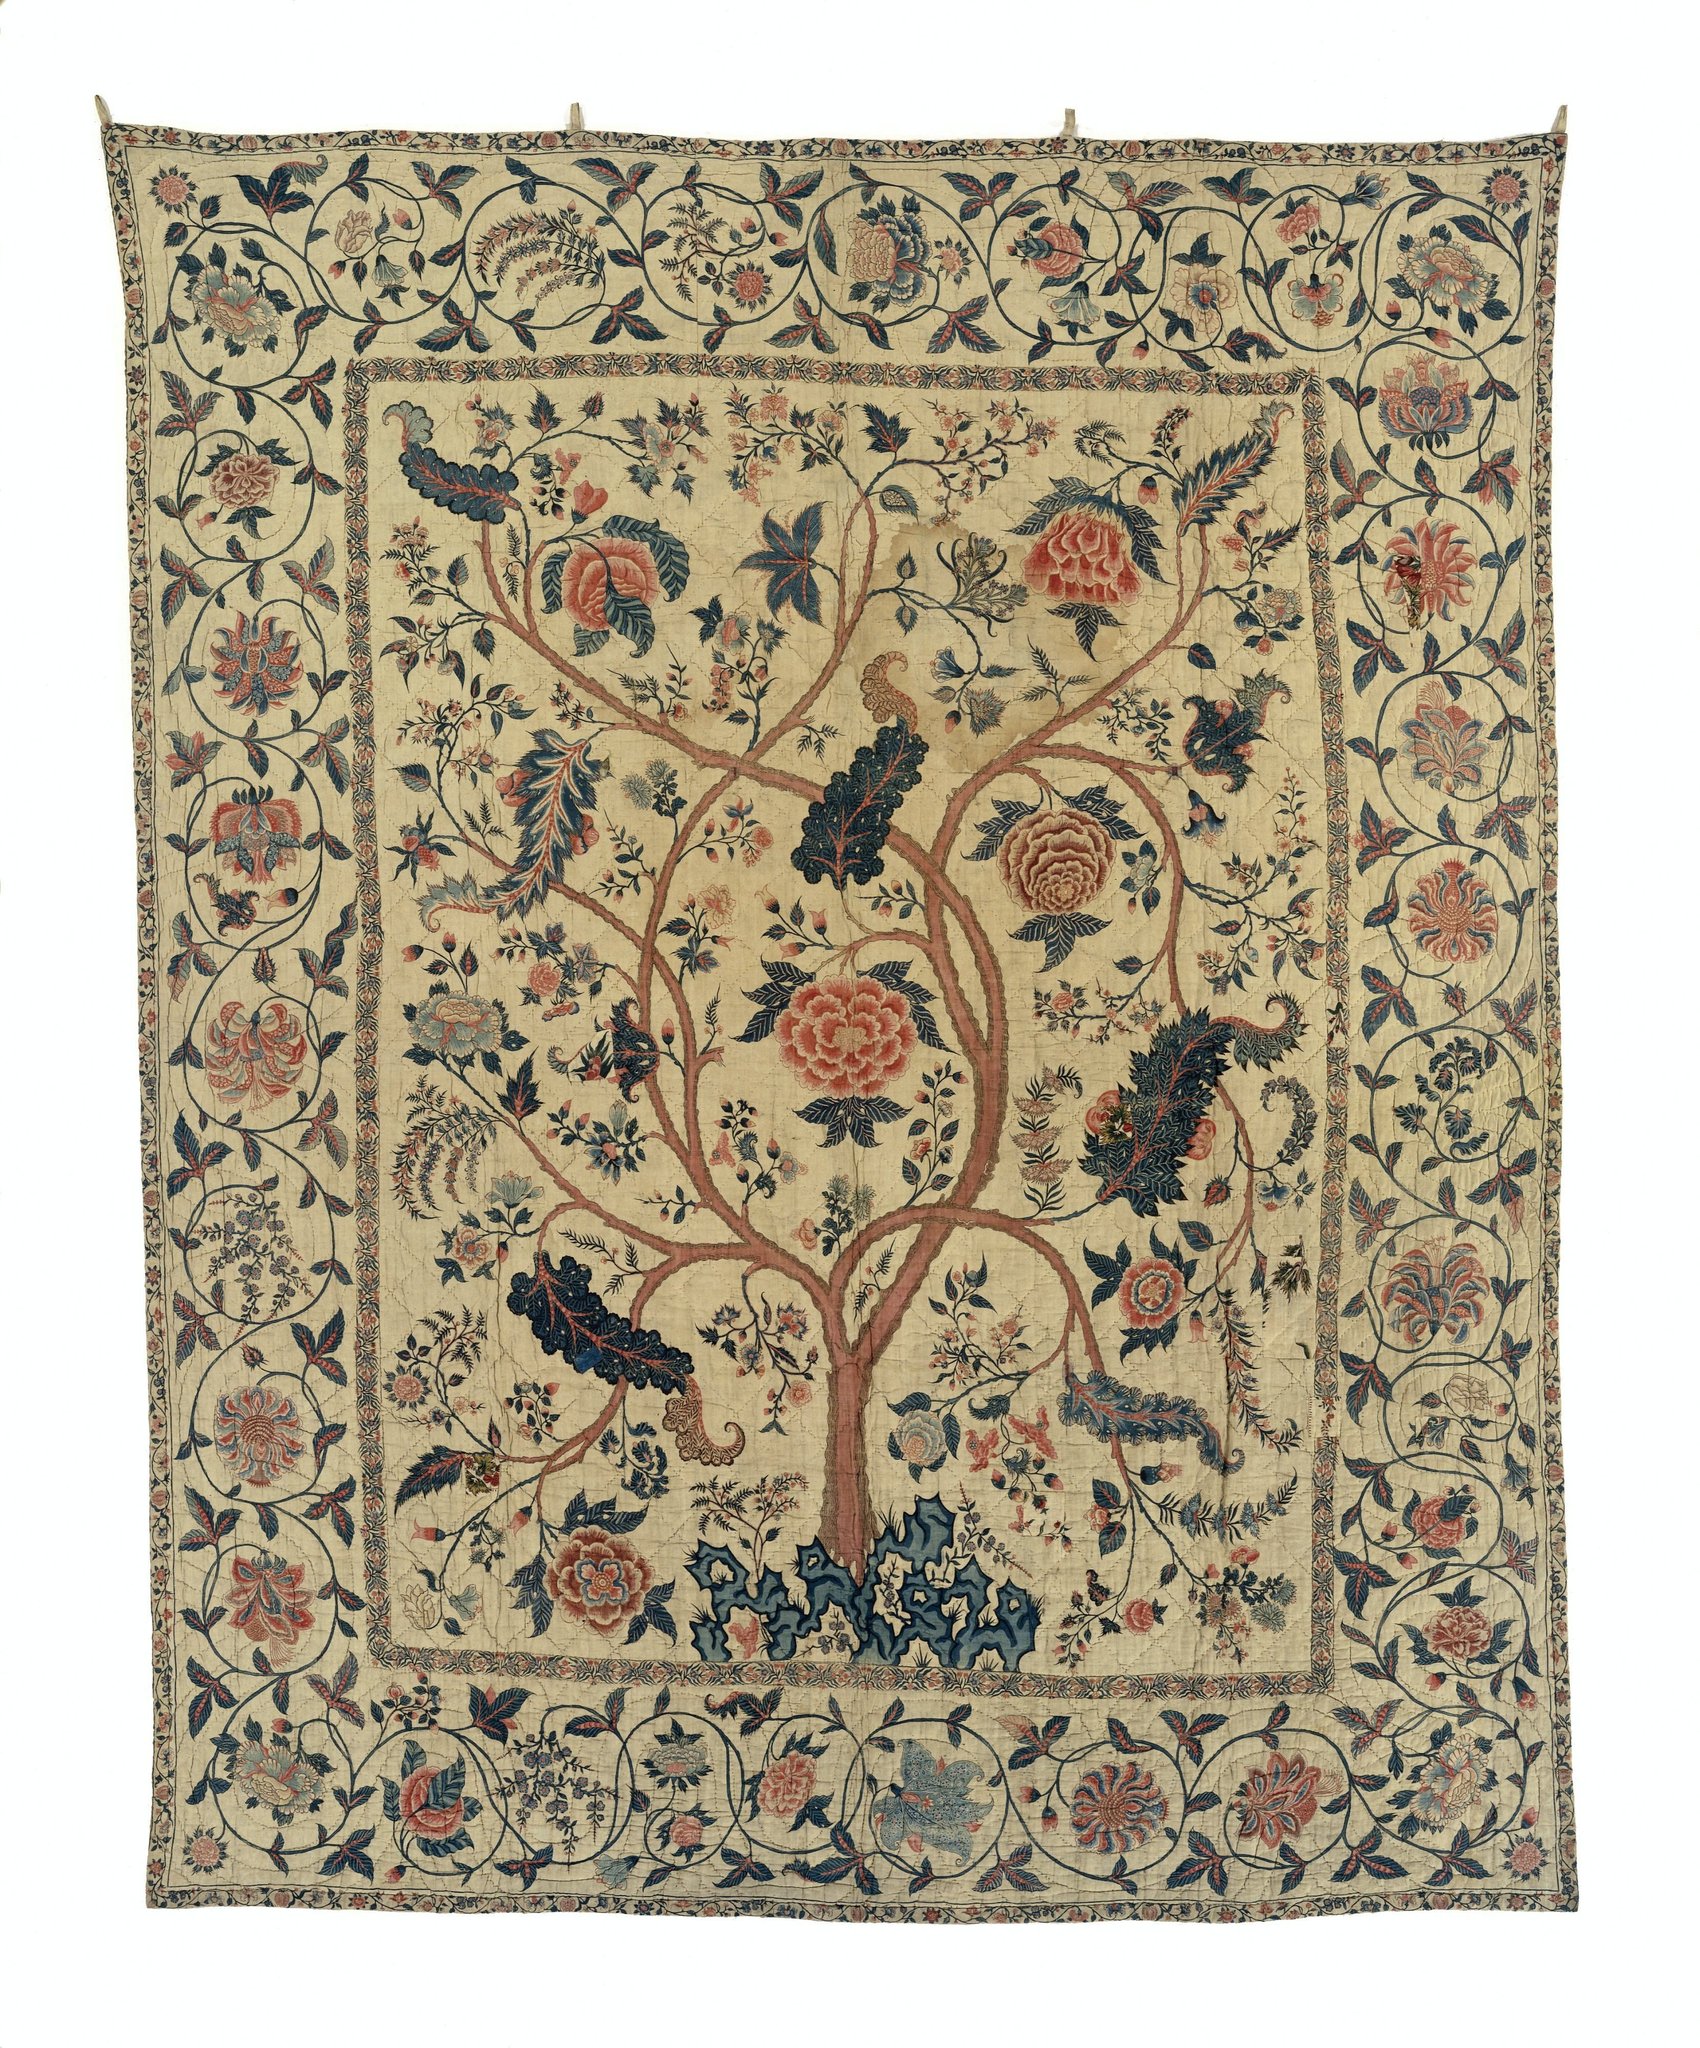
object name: blanket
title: Gestikte, gewatteerde sitsen deken of sprei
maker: Anonymous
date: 1740-1770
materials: textile, cotton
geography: northwest india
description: Gestikte en gewatteerde sitsen deken of sprei. In het middenvak staat een boom met slingerende takken en grote bloemen, waartussen kleine bloemtakken. De rand heeft slingerende ranken met bladeren en bloemen.